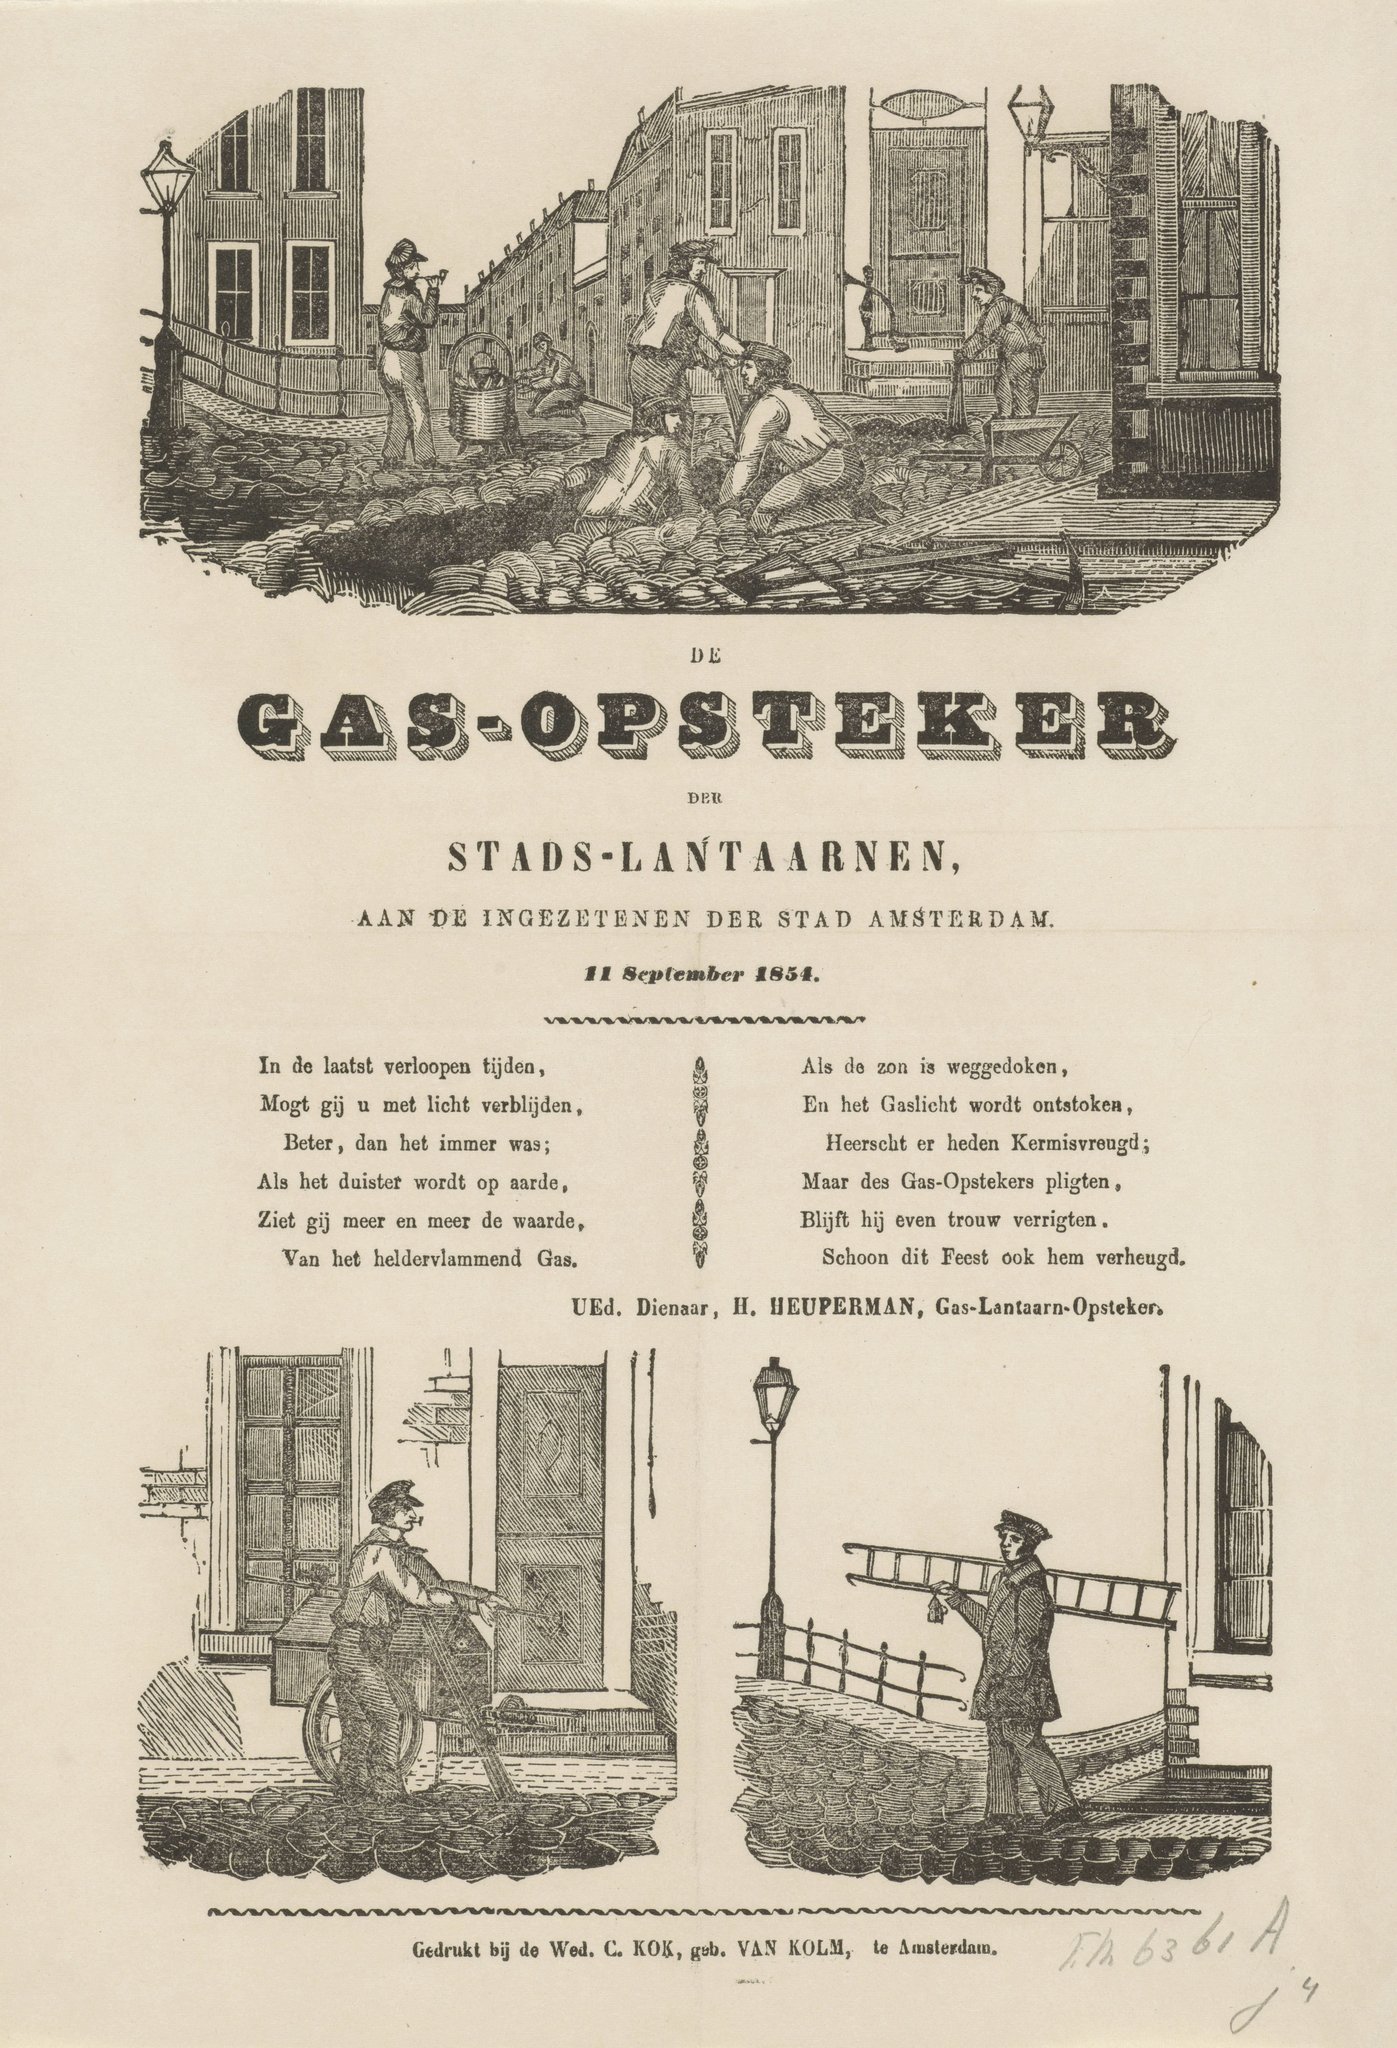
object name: print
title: Kermisprent van de gaslantaarnopstekers van Amsterdam voor het jaar 1854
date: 1854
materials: paper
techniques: letterpress printing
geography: amsterdam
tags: gas-lamp (+ kindling a light; lit, burning light, lamp, candle), gas supply, digging (industrial process), street lighting, street, amsterdam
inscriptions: collector's mark: Lugt 2228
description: Kermisprent van de Amsterdamse gaslantaarnopstekers voor het jaar 1854. Centraal een vers in twee kolommen. Bovenaan een straat in Amsterdam opgebroken voor de aanleg van de gasleiding. Onderaan twee gasfitters. Van de gaslantaarnopsteker: H. Heuperman.